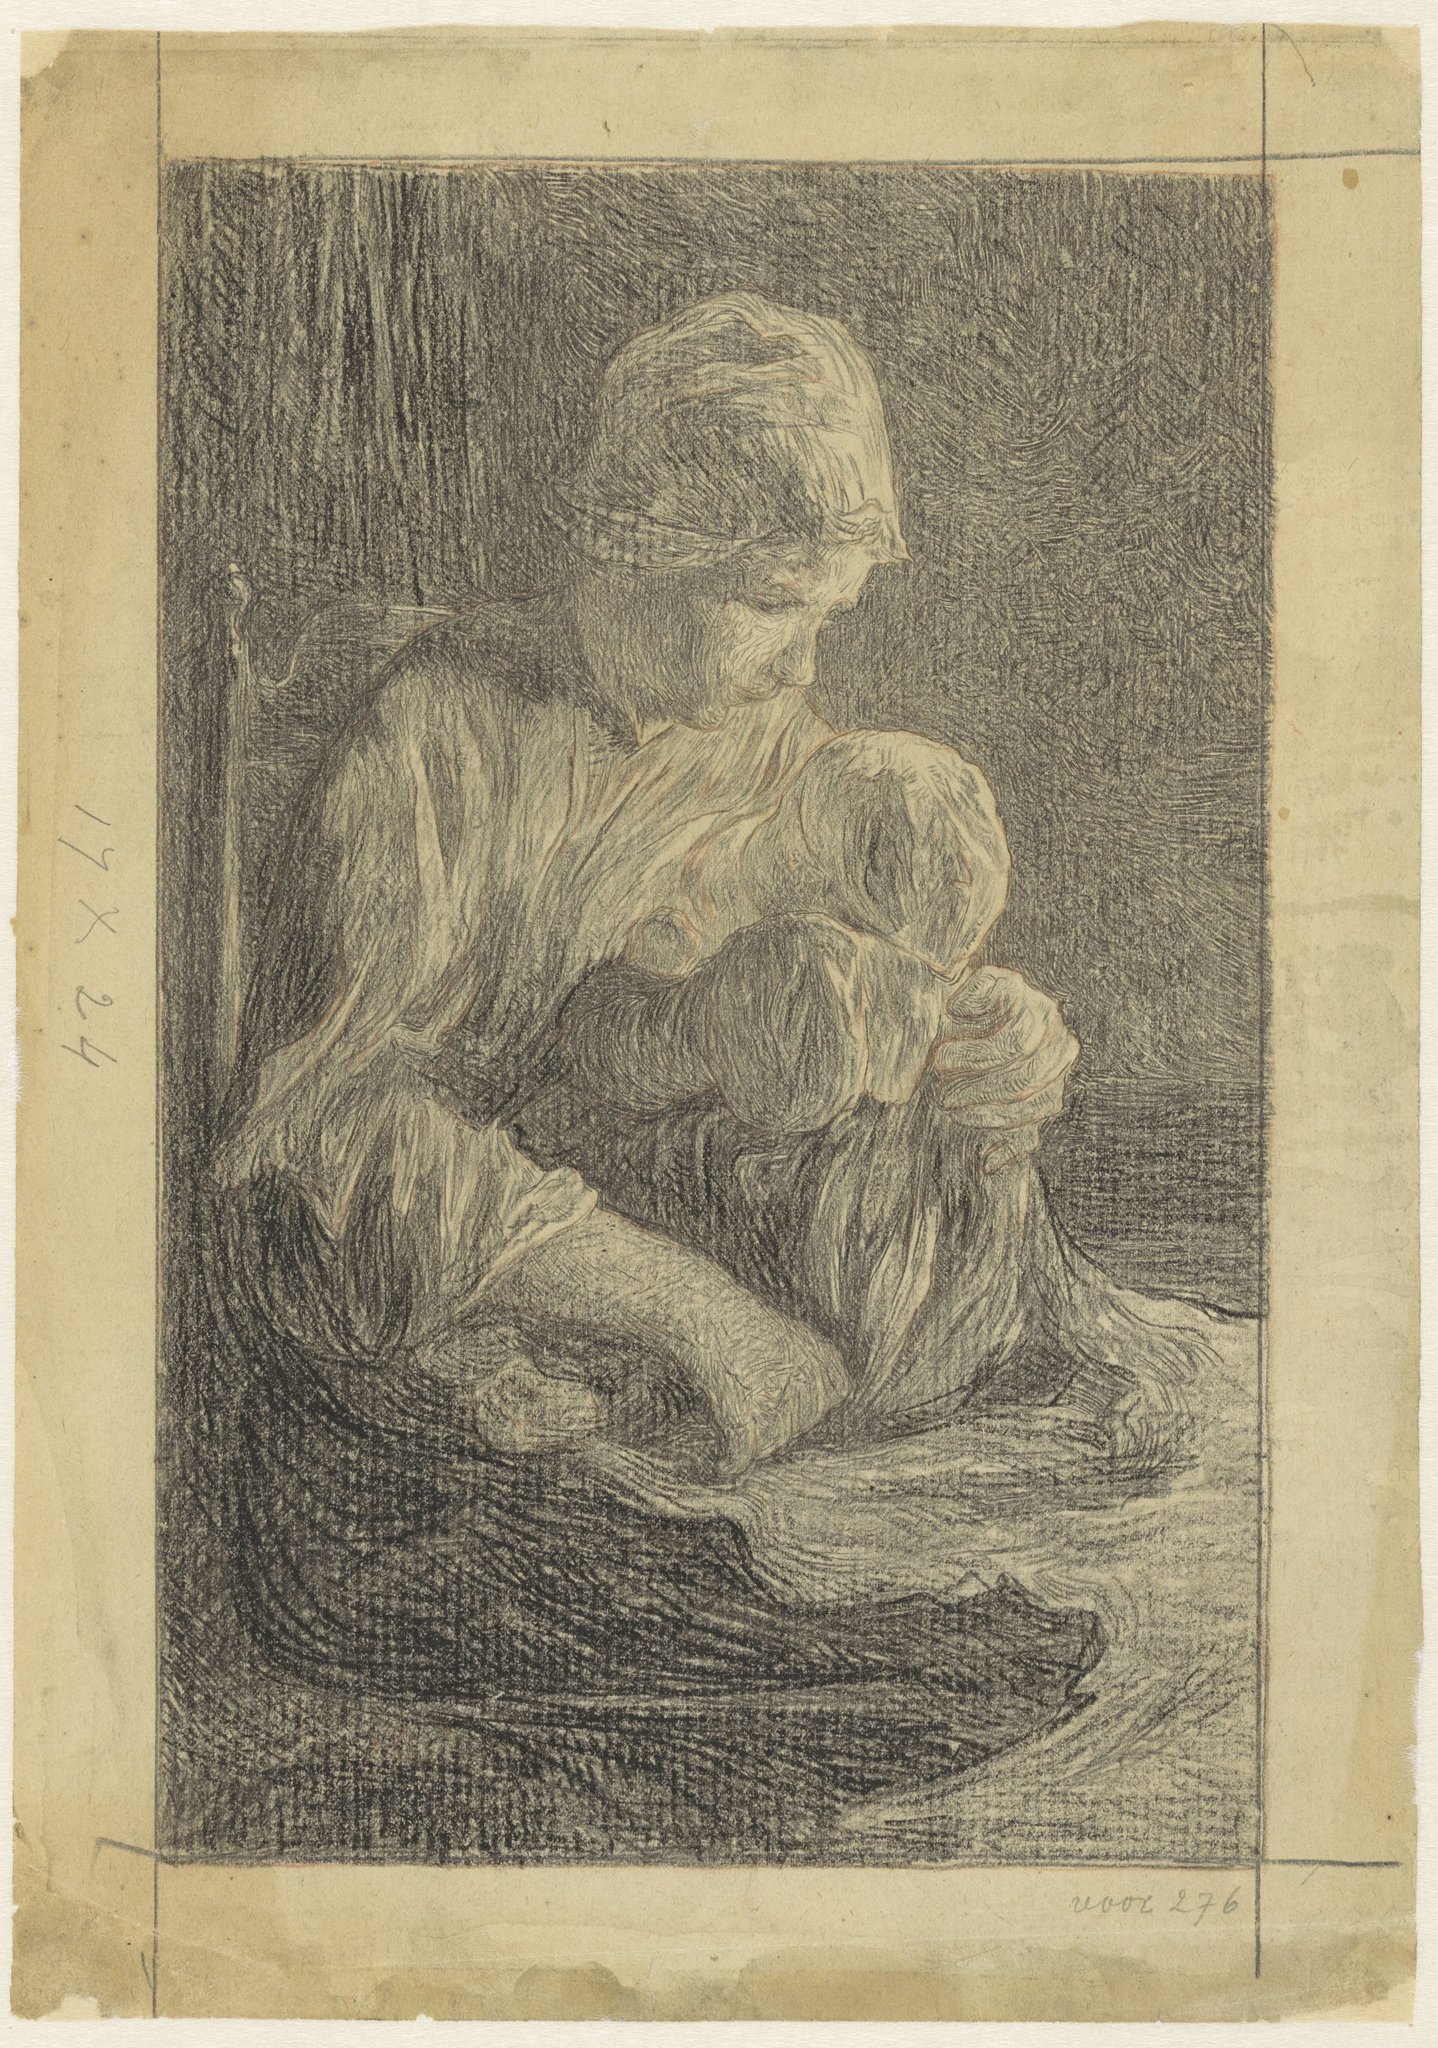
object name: drawing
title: Moeder met kind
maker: jan veth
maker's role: designer, draughtsman, painter, print maker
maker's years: 1864-1925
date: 1874-1925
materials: chalk, paper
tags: mother and baby or young child